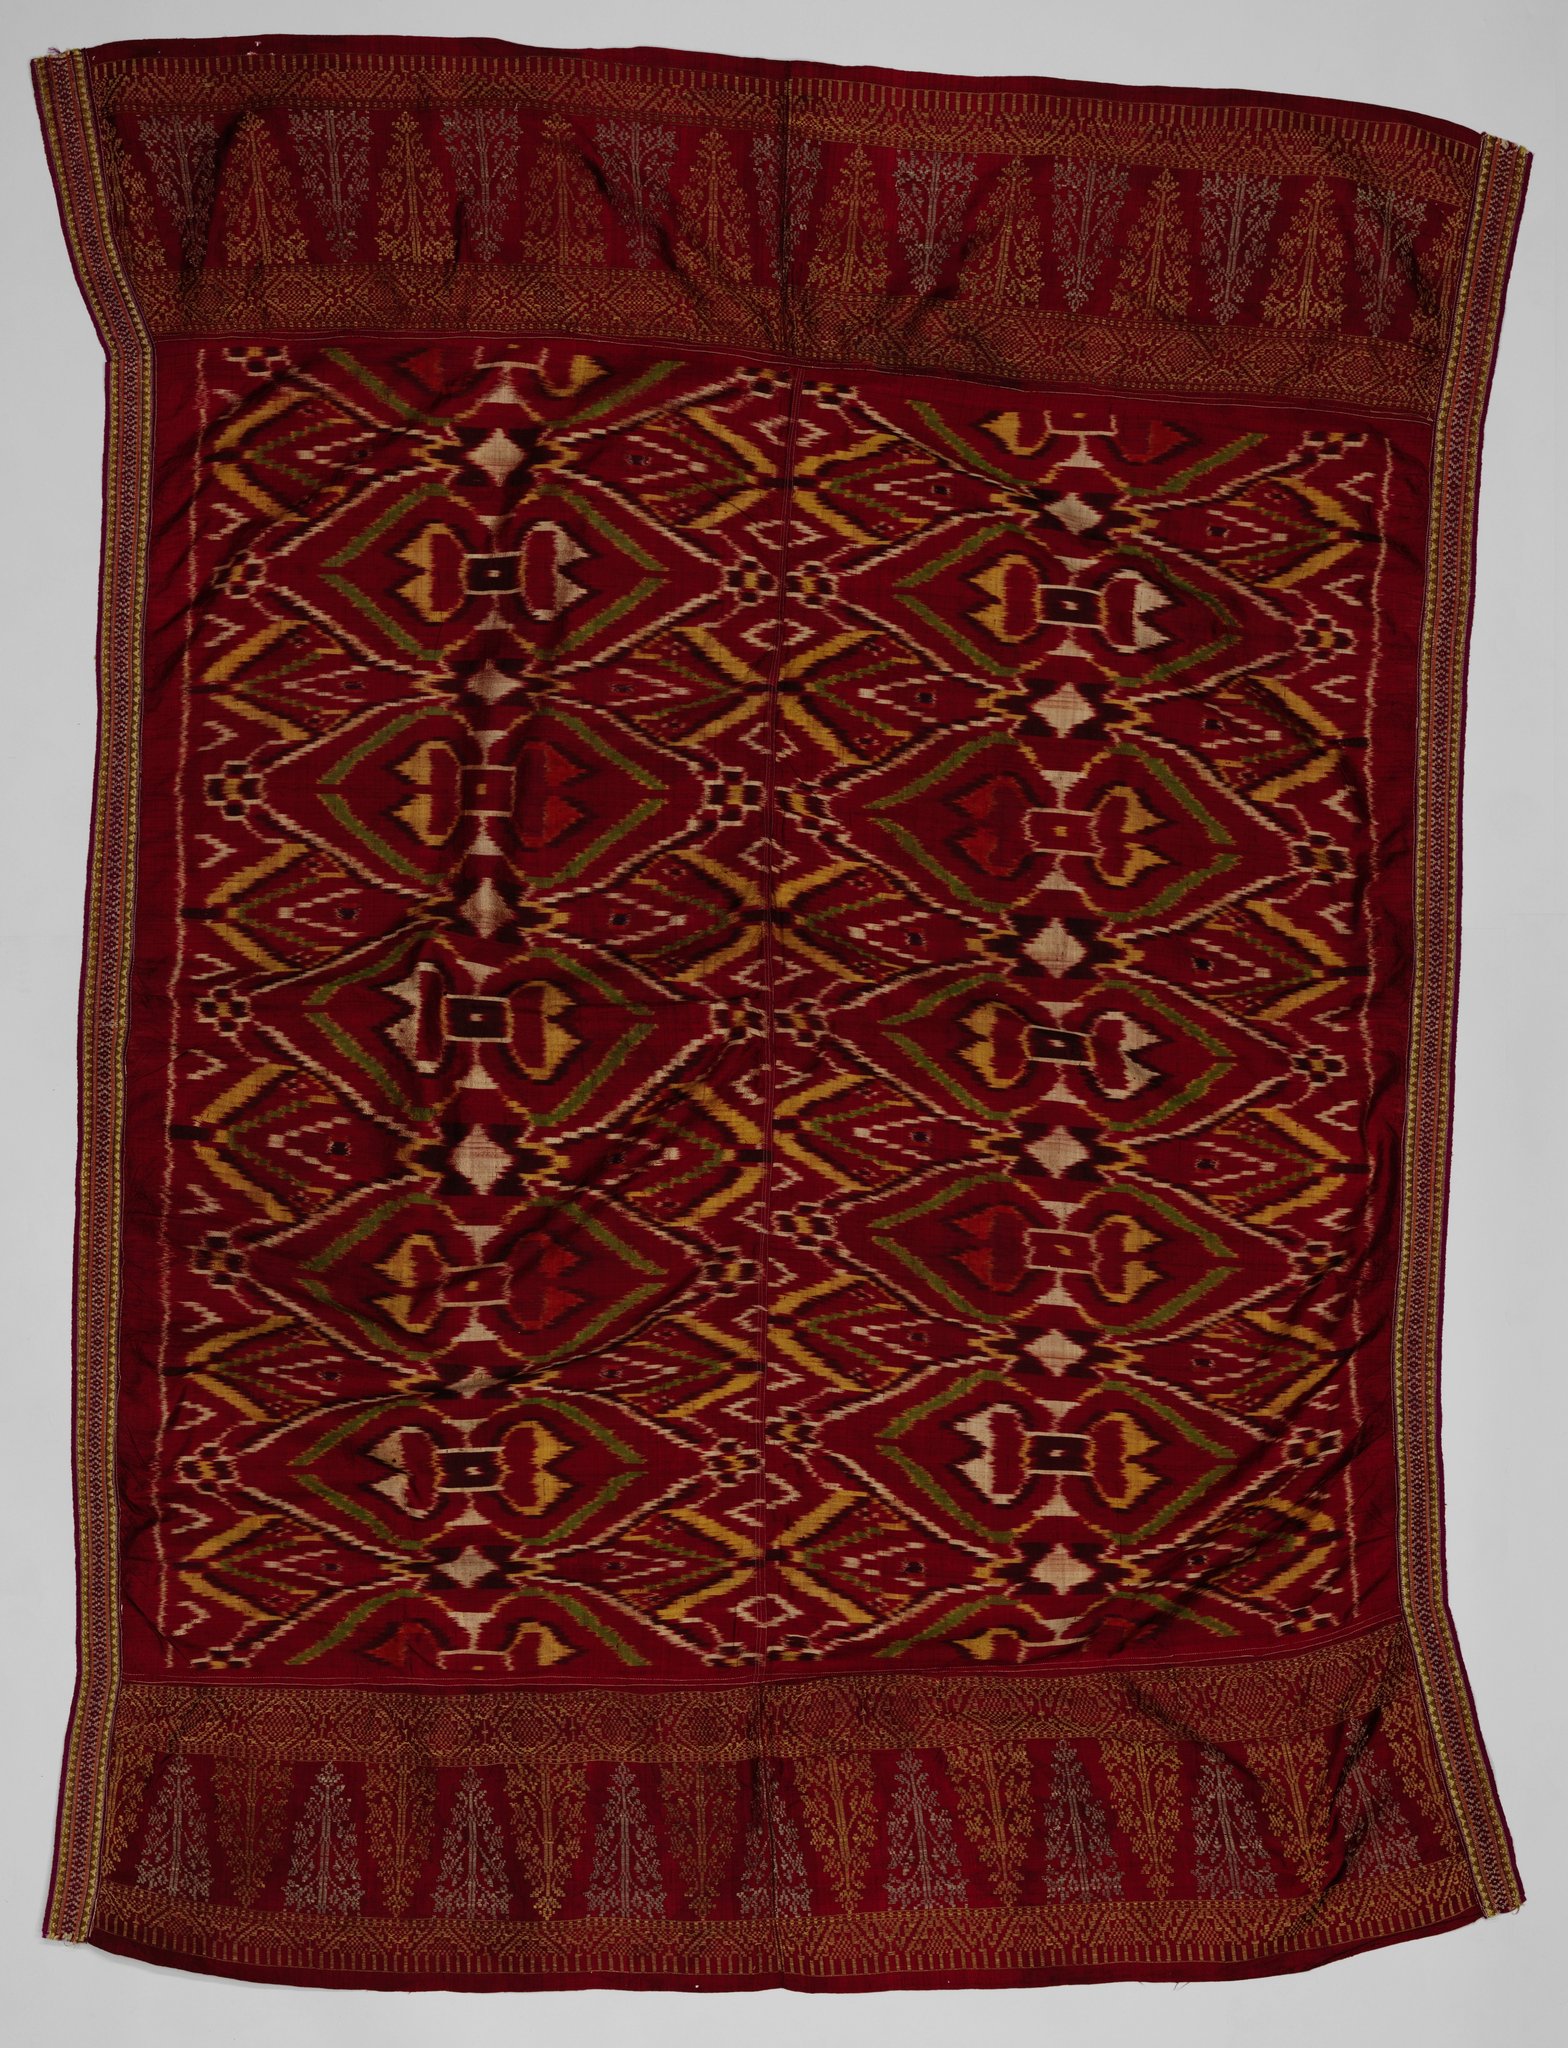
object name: cloth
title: Tempeldoek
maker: Anonymous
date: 1900-1949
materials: gold thread, silk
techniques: weave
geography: bali